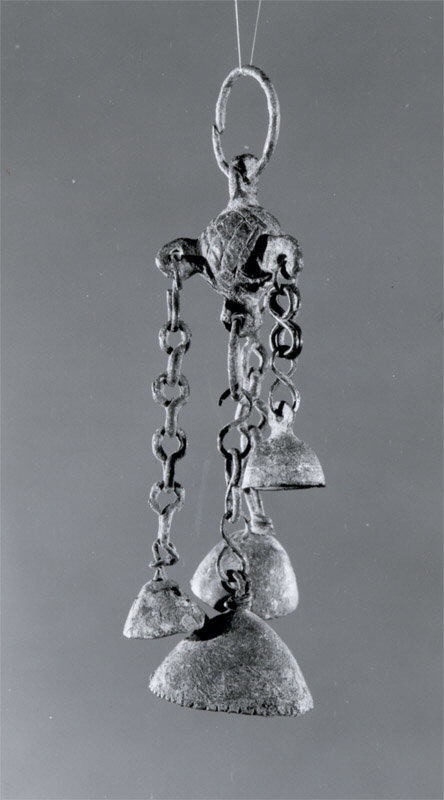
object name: bell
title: Bells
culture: iranian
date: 1000-1 BCE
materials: bronze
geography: iran